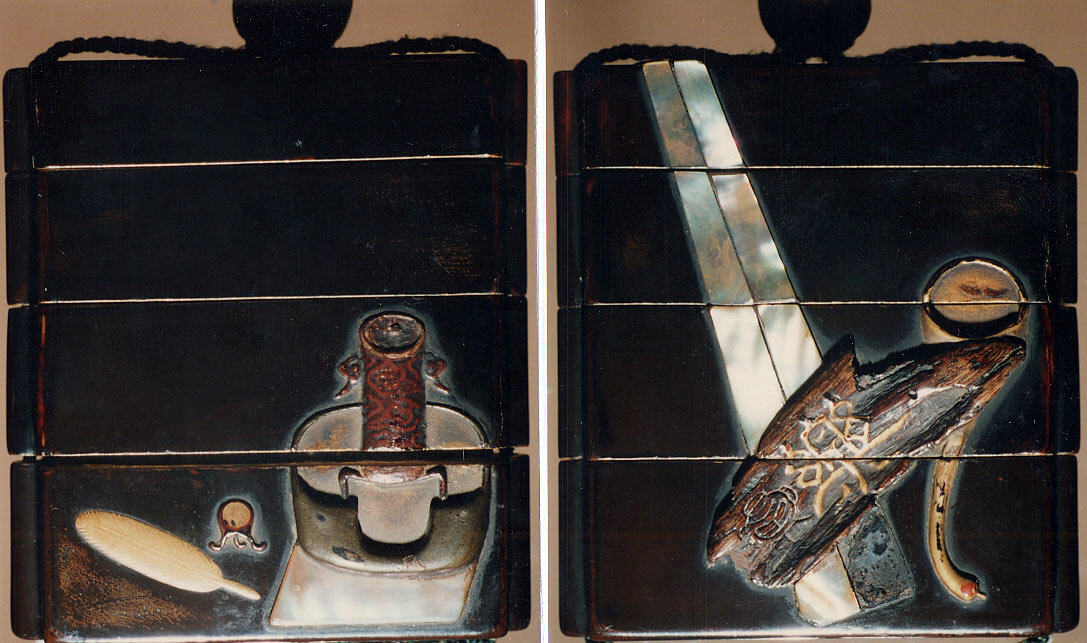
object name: inrō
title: Case (Inrō) with Design of Objects for Tea Ceremony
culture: japanese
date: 1701-1800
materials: gold, lacquer, wood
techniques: fundame, hiramakie, inlay, roiro